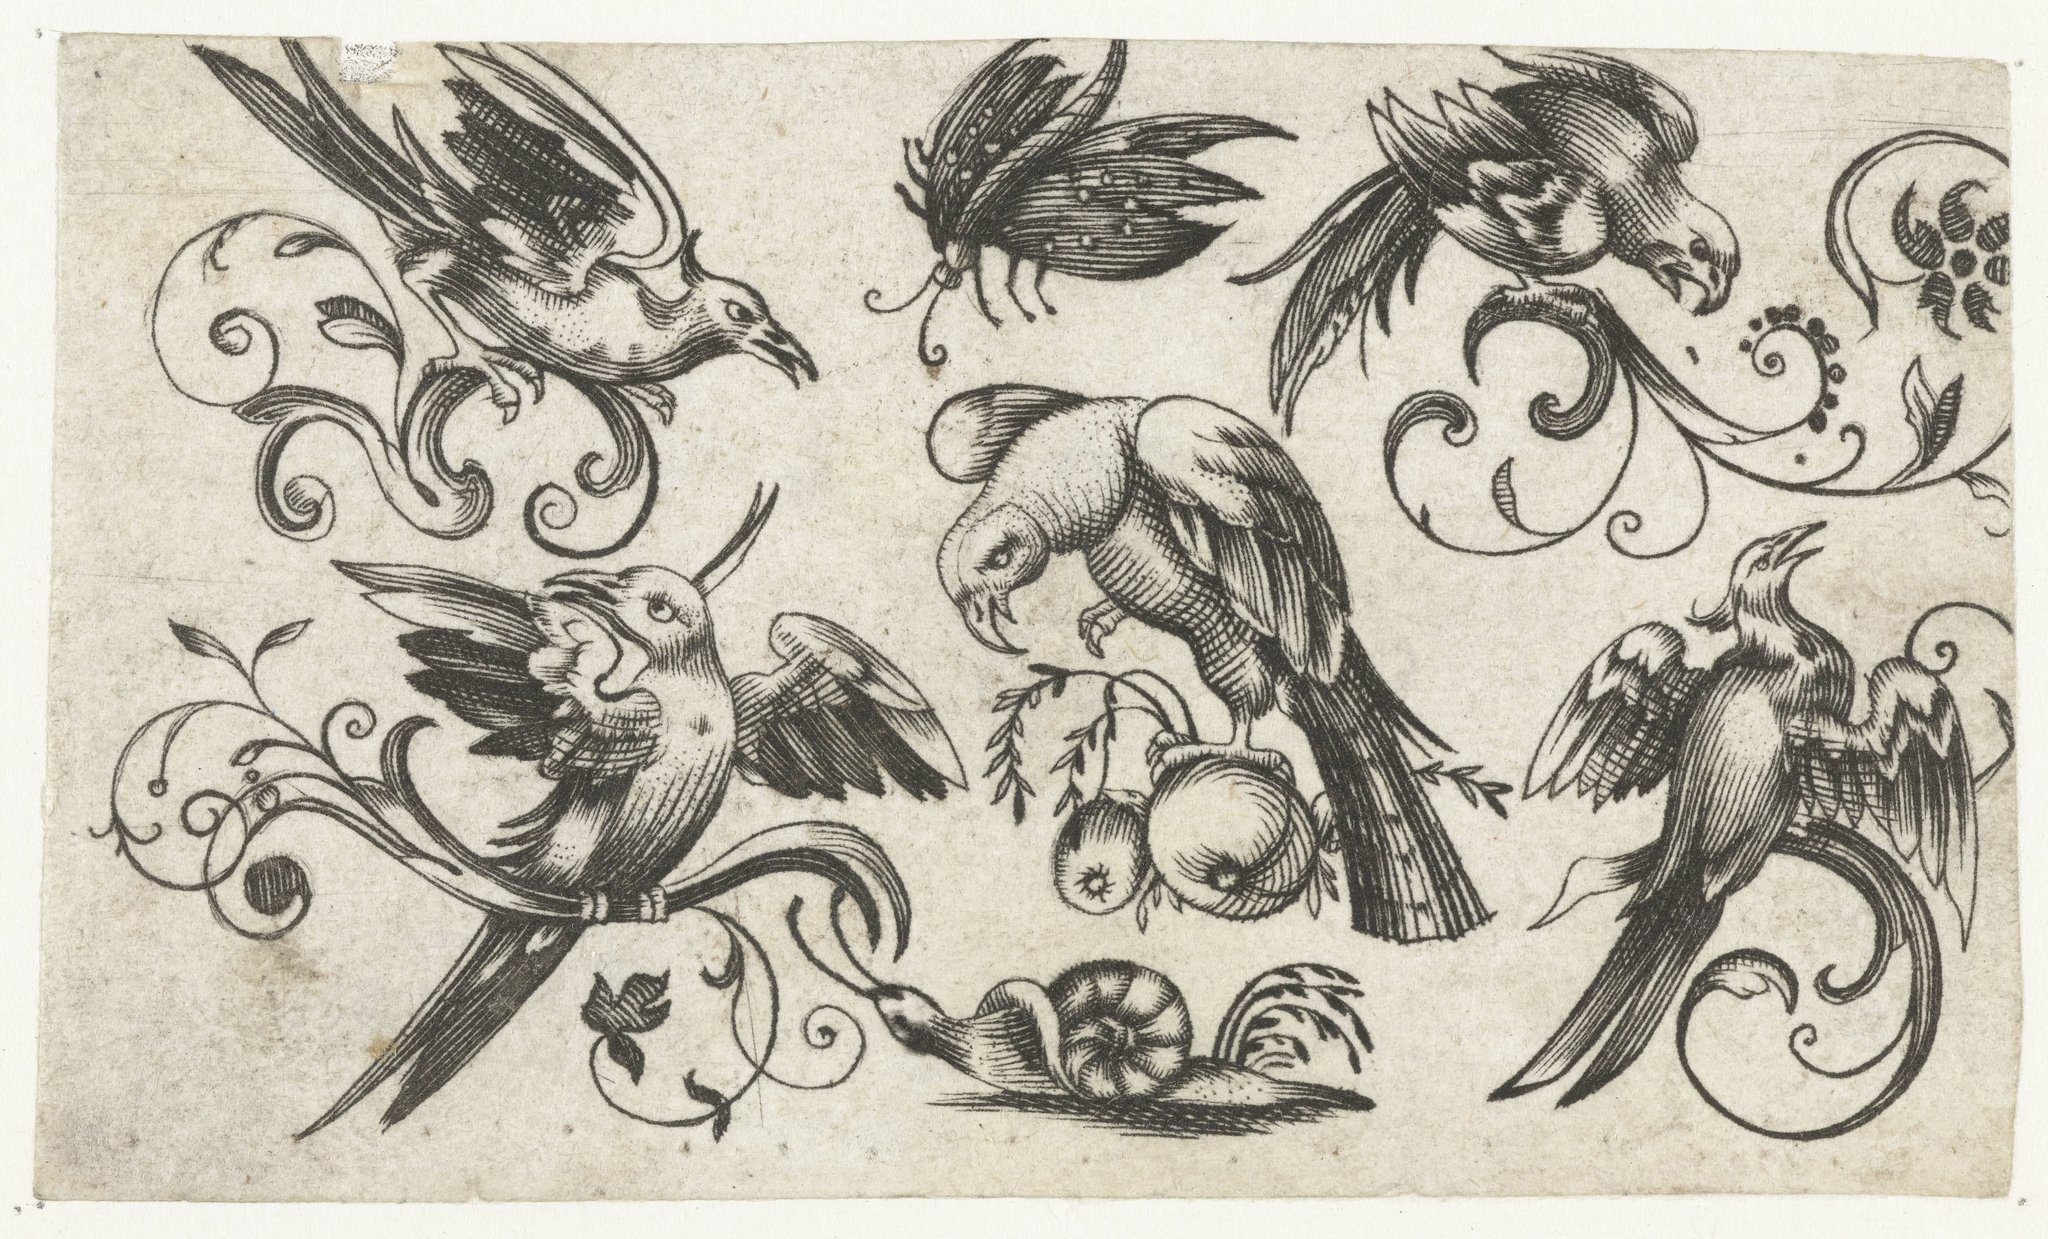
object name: print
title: Vijf vogels, een vlinder en een slak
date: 1600-1699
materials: paper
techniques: engraving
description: Kopie naar prent met vogels uitgegeven door Johannes Janssonius (zie RP-P-1965-905).